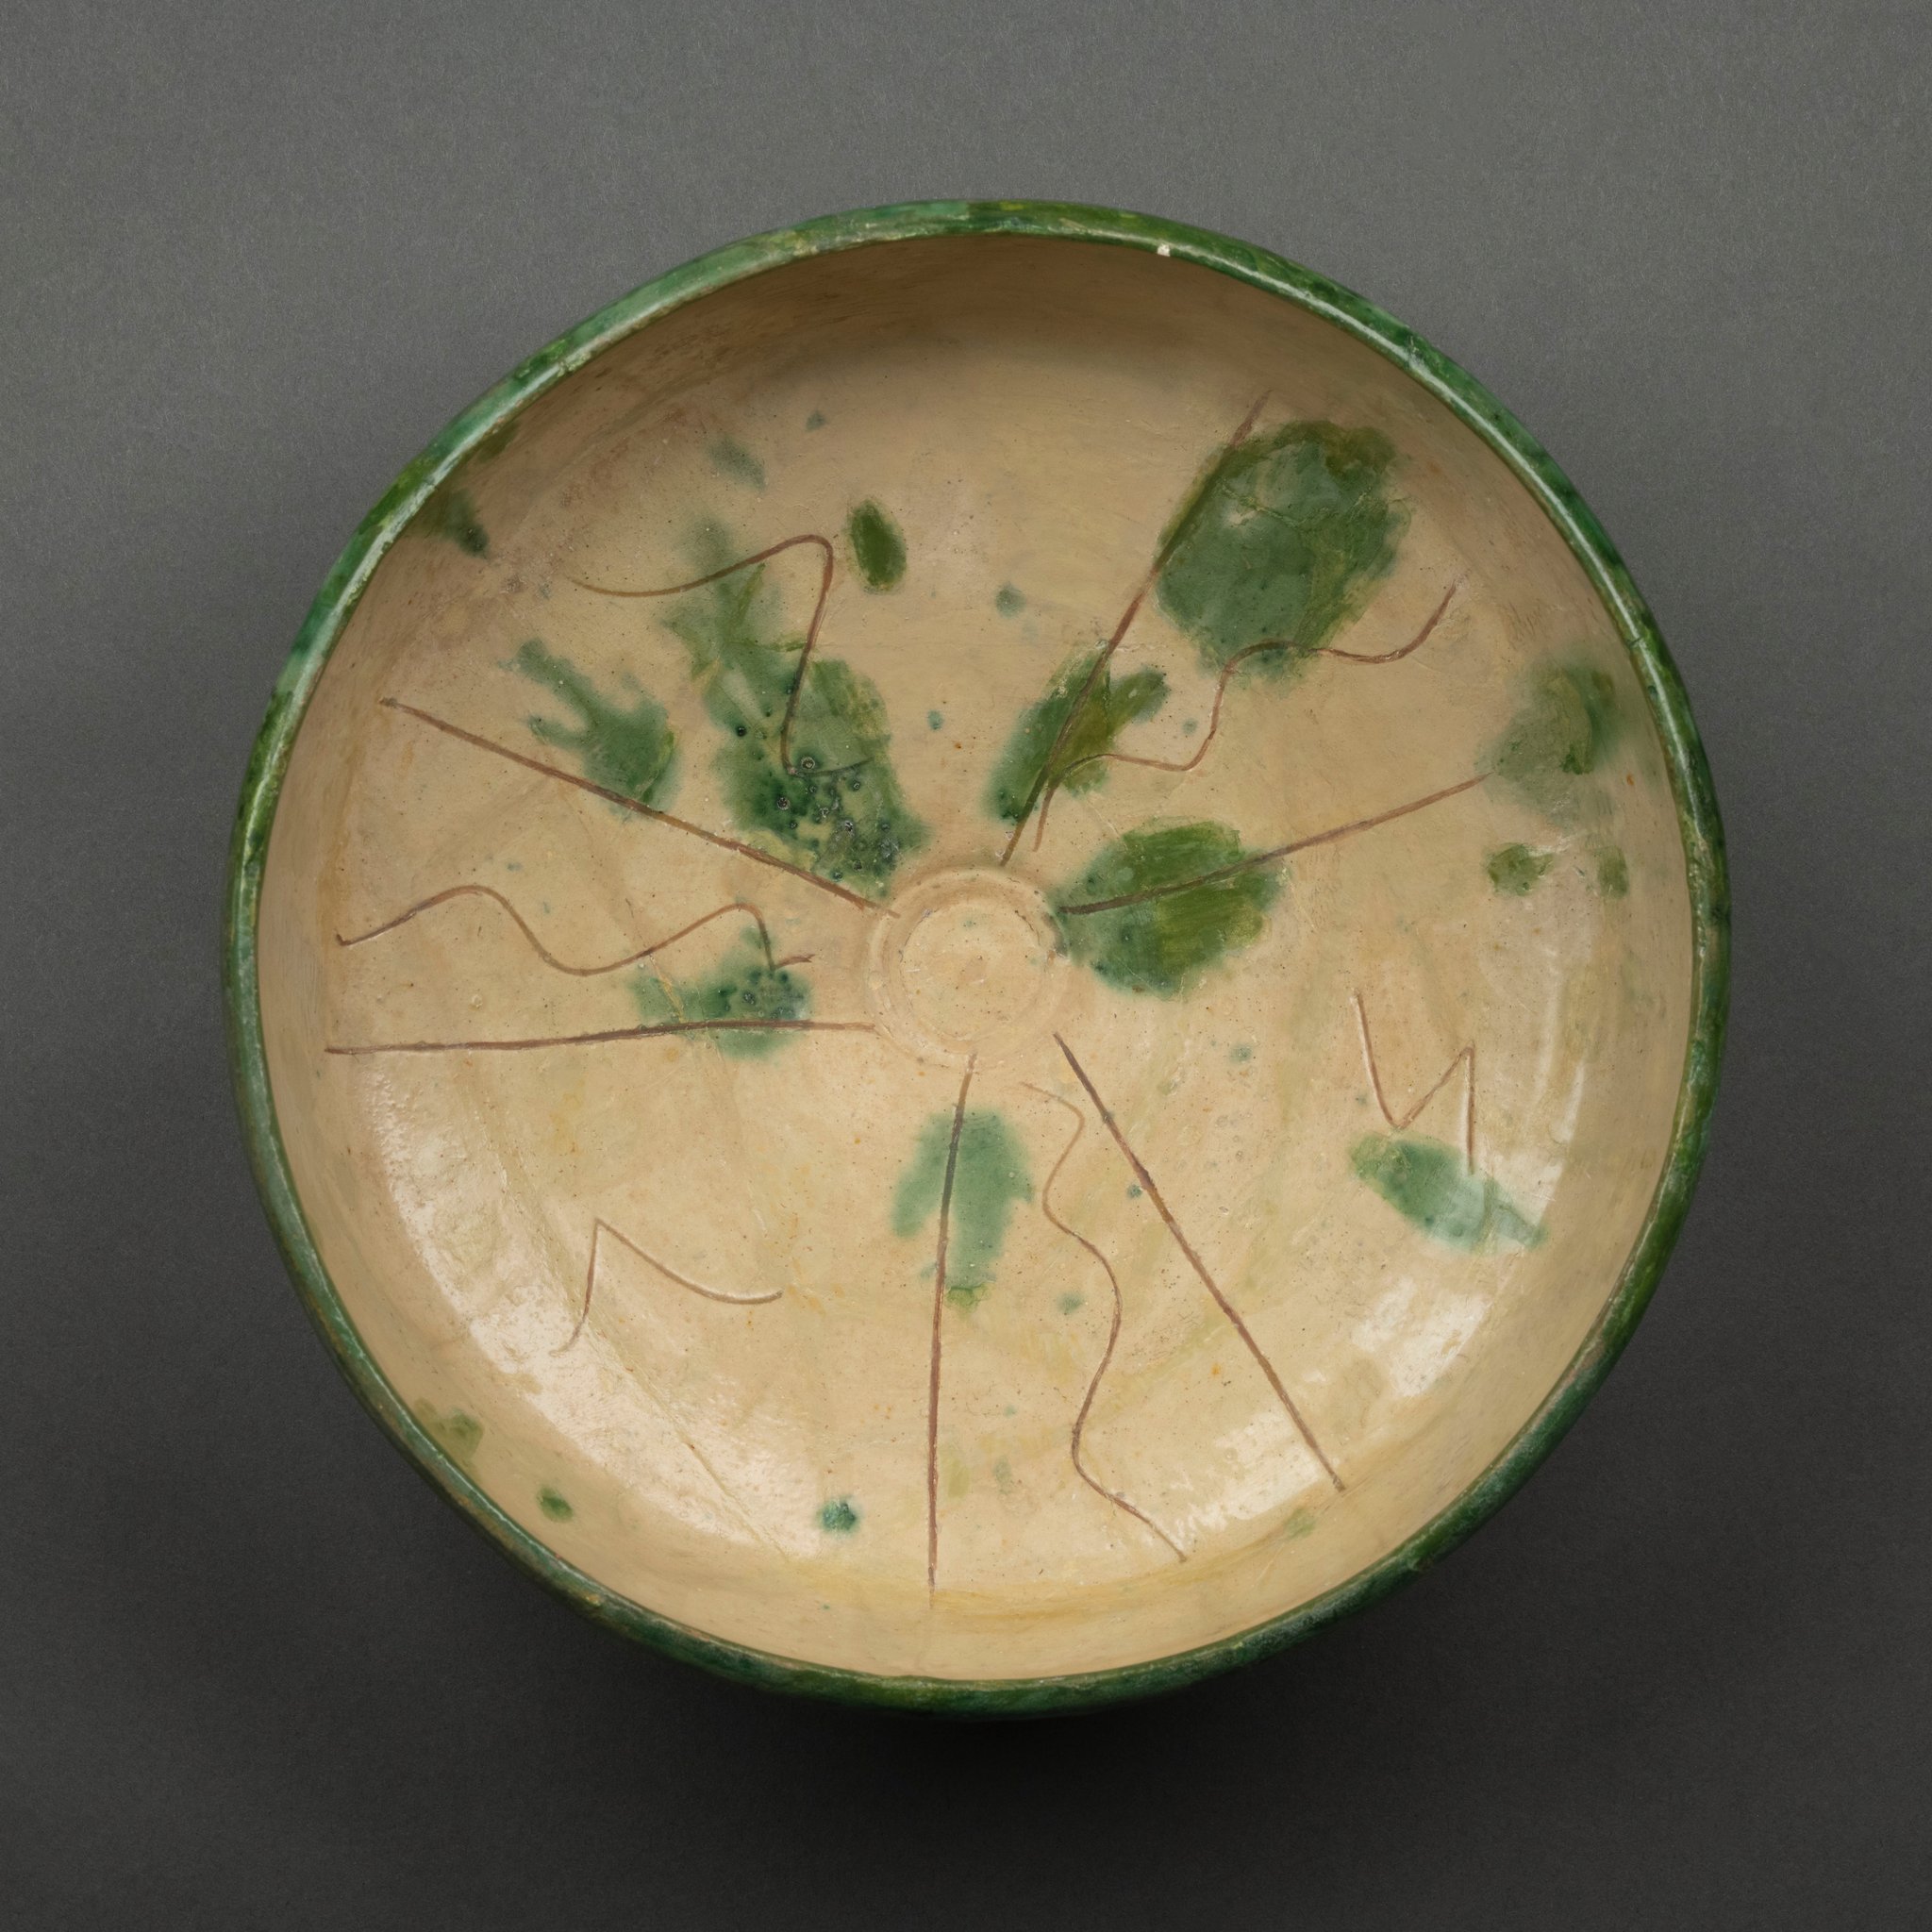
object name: bowl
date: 801-900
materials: earthenware, glaze, pigment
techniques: incising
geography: iran